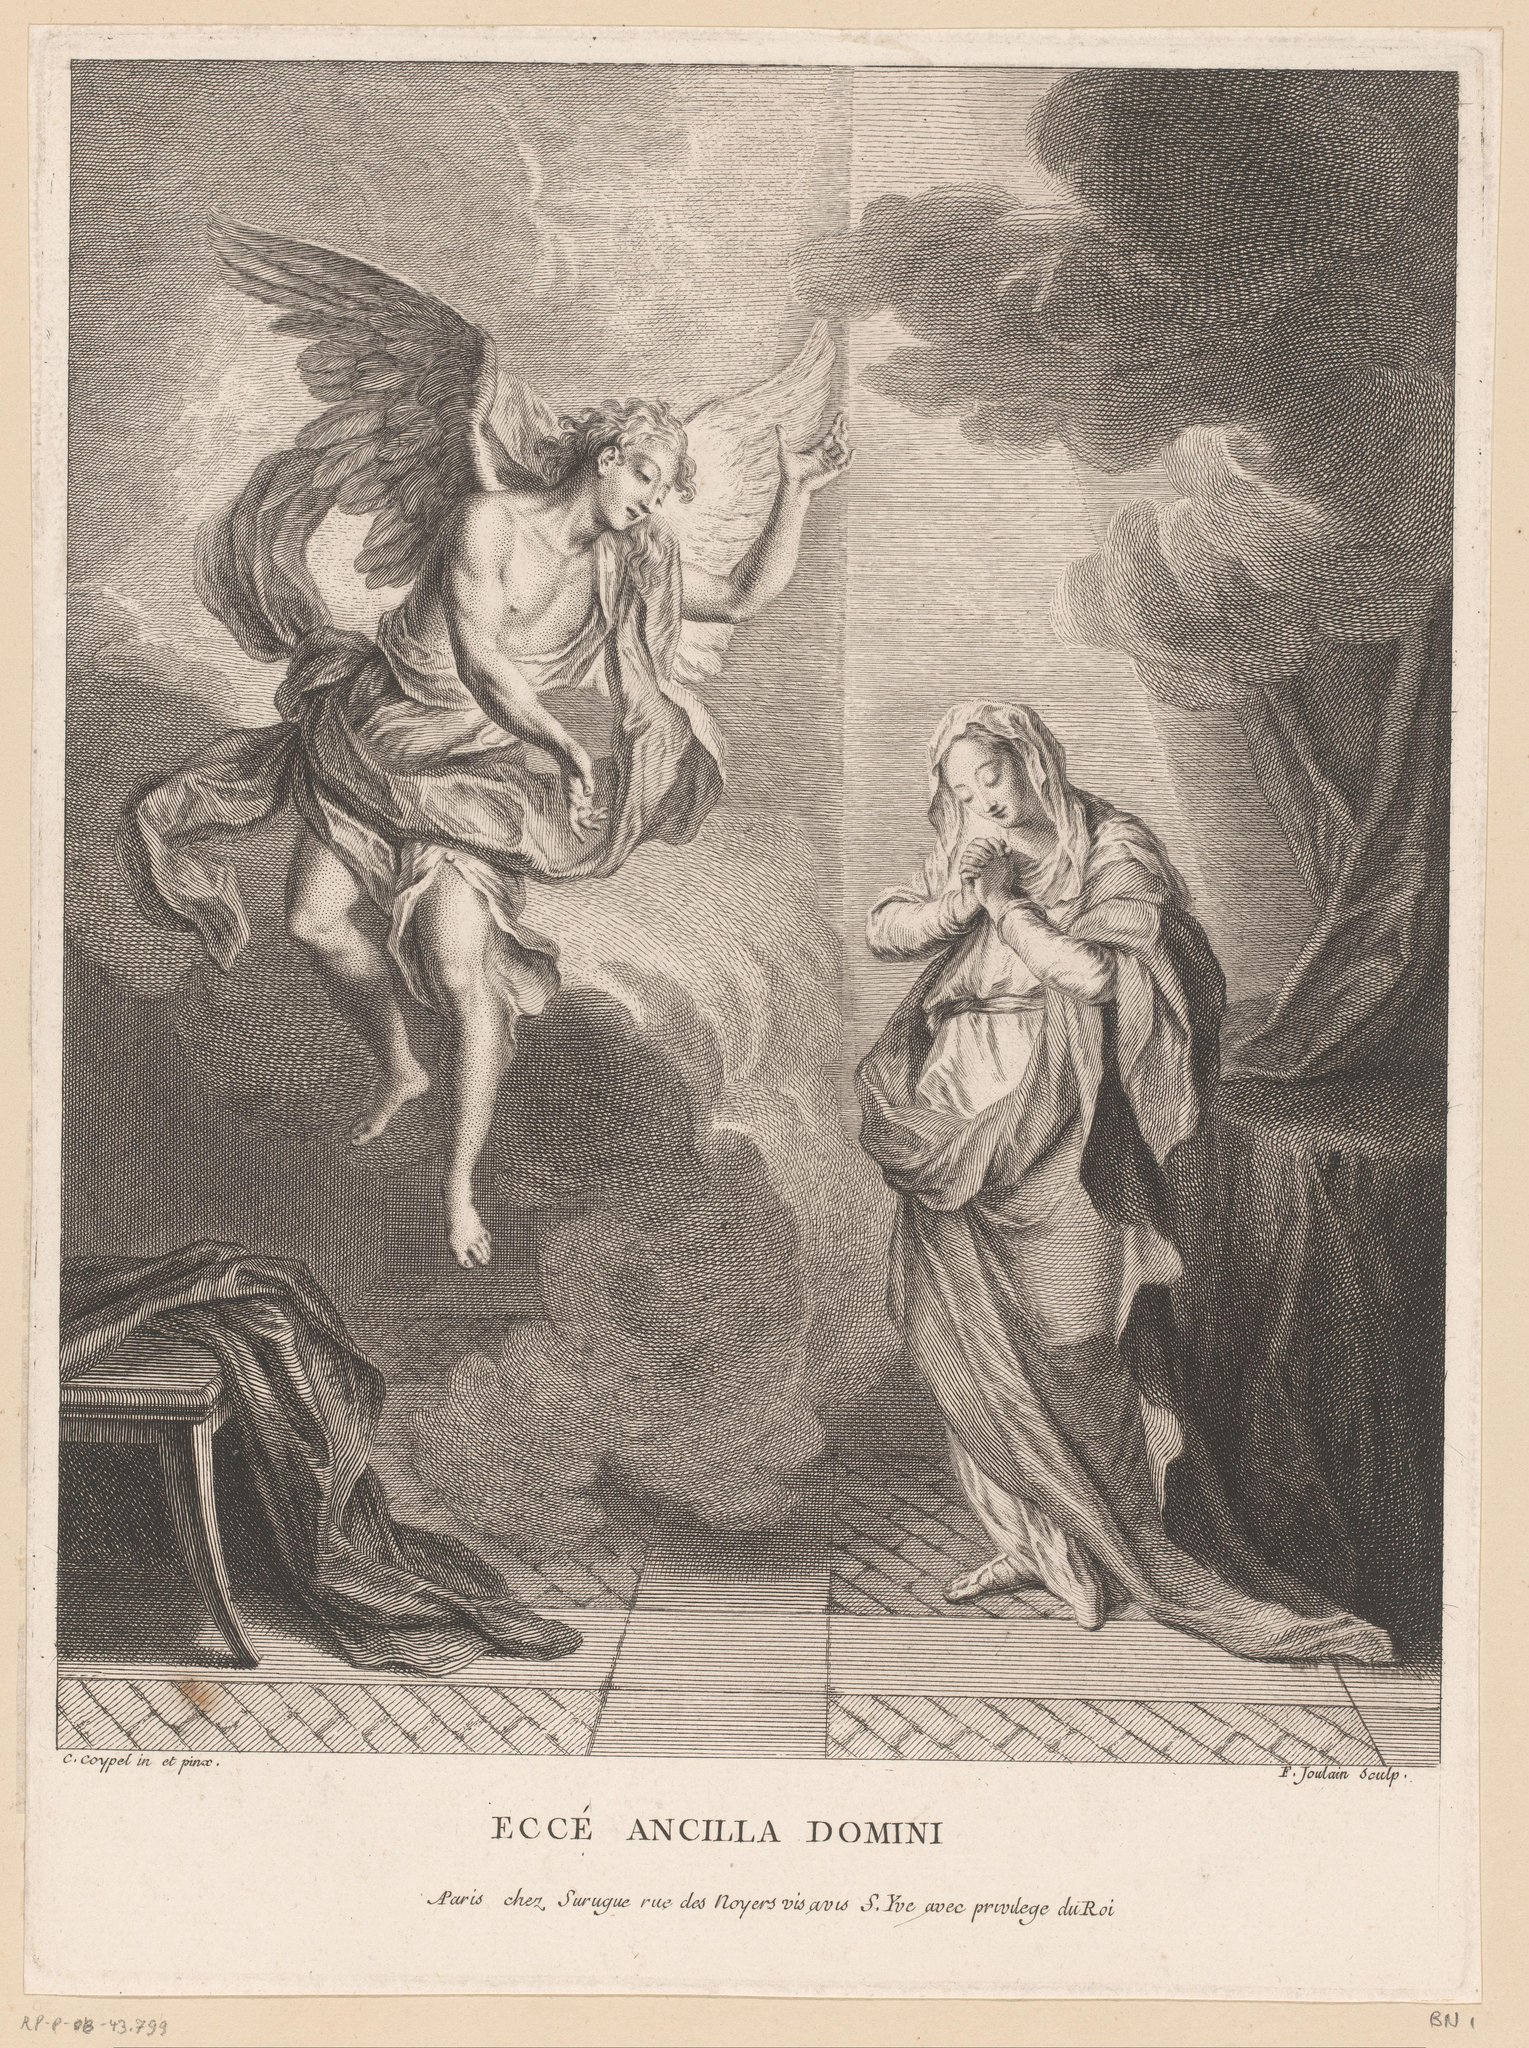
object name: print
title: Annunciatie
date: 1723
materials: paper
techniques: engraving, etching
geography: france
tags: the annunciation: mary, usually reading, is visited by the angel (sometimes a woman overhears the conversation)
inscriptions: collector's mark: Lugt 240